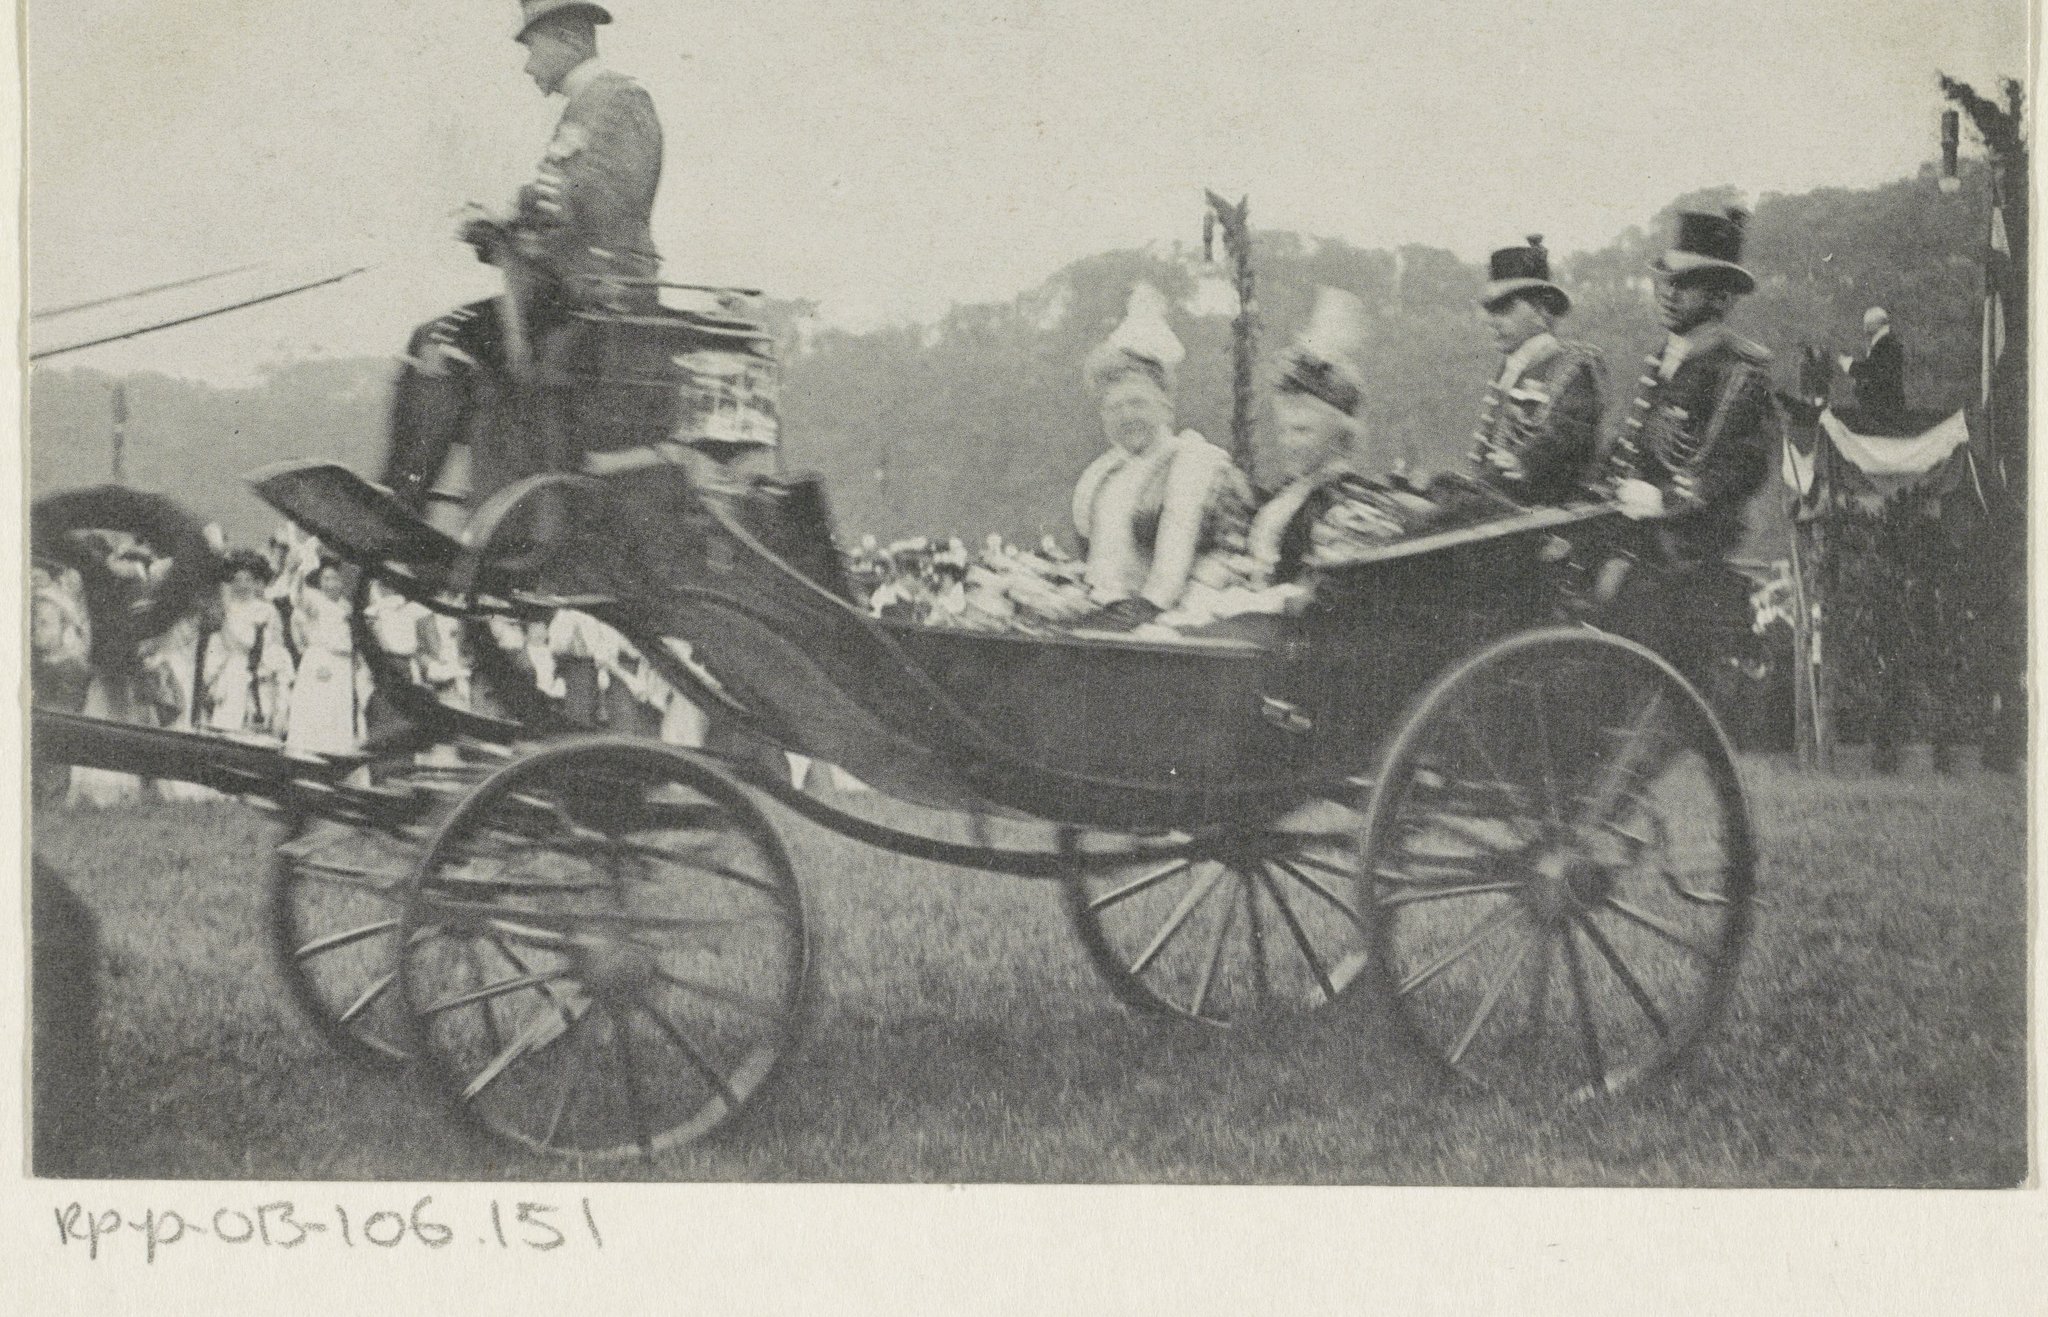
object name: photomechanical print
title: Aubade ter ere van de geboorte van Juliana, koningin der Nederlanden, te Den Haag op 8 juni 1909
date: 1909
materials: paper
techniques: photograph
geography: netherlands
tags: the hague, juliana of the netherlands, animal traction, animal-drawn vehicle (carriage etc.)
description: De hier vermelde titel verwijst naar de hoogst verkregen titel van de geportretteerde, niet per se naar de titel die de geportretteerde op deze voorstelling draagt.